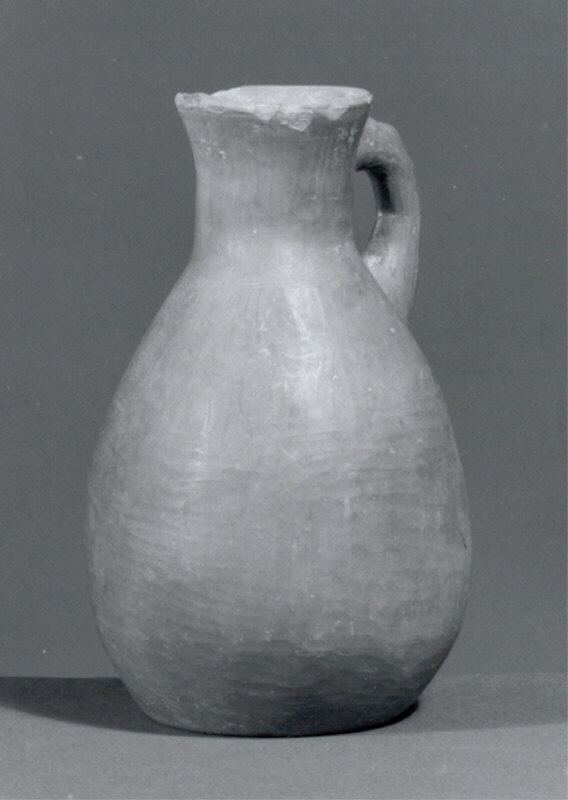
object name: jug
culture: iranian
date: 600-400 BCE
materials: ceramic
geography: iran